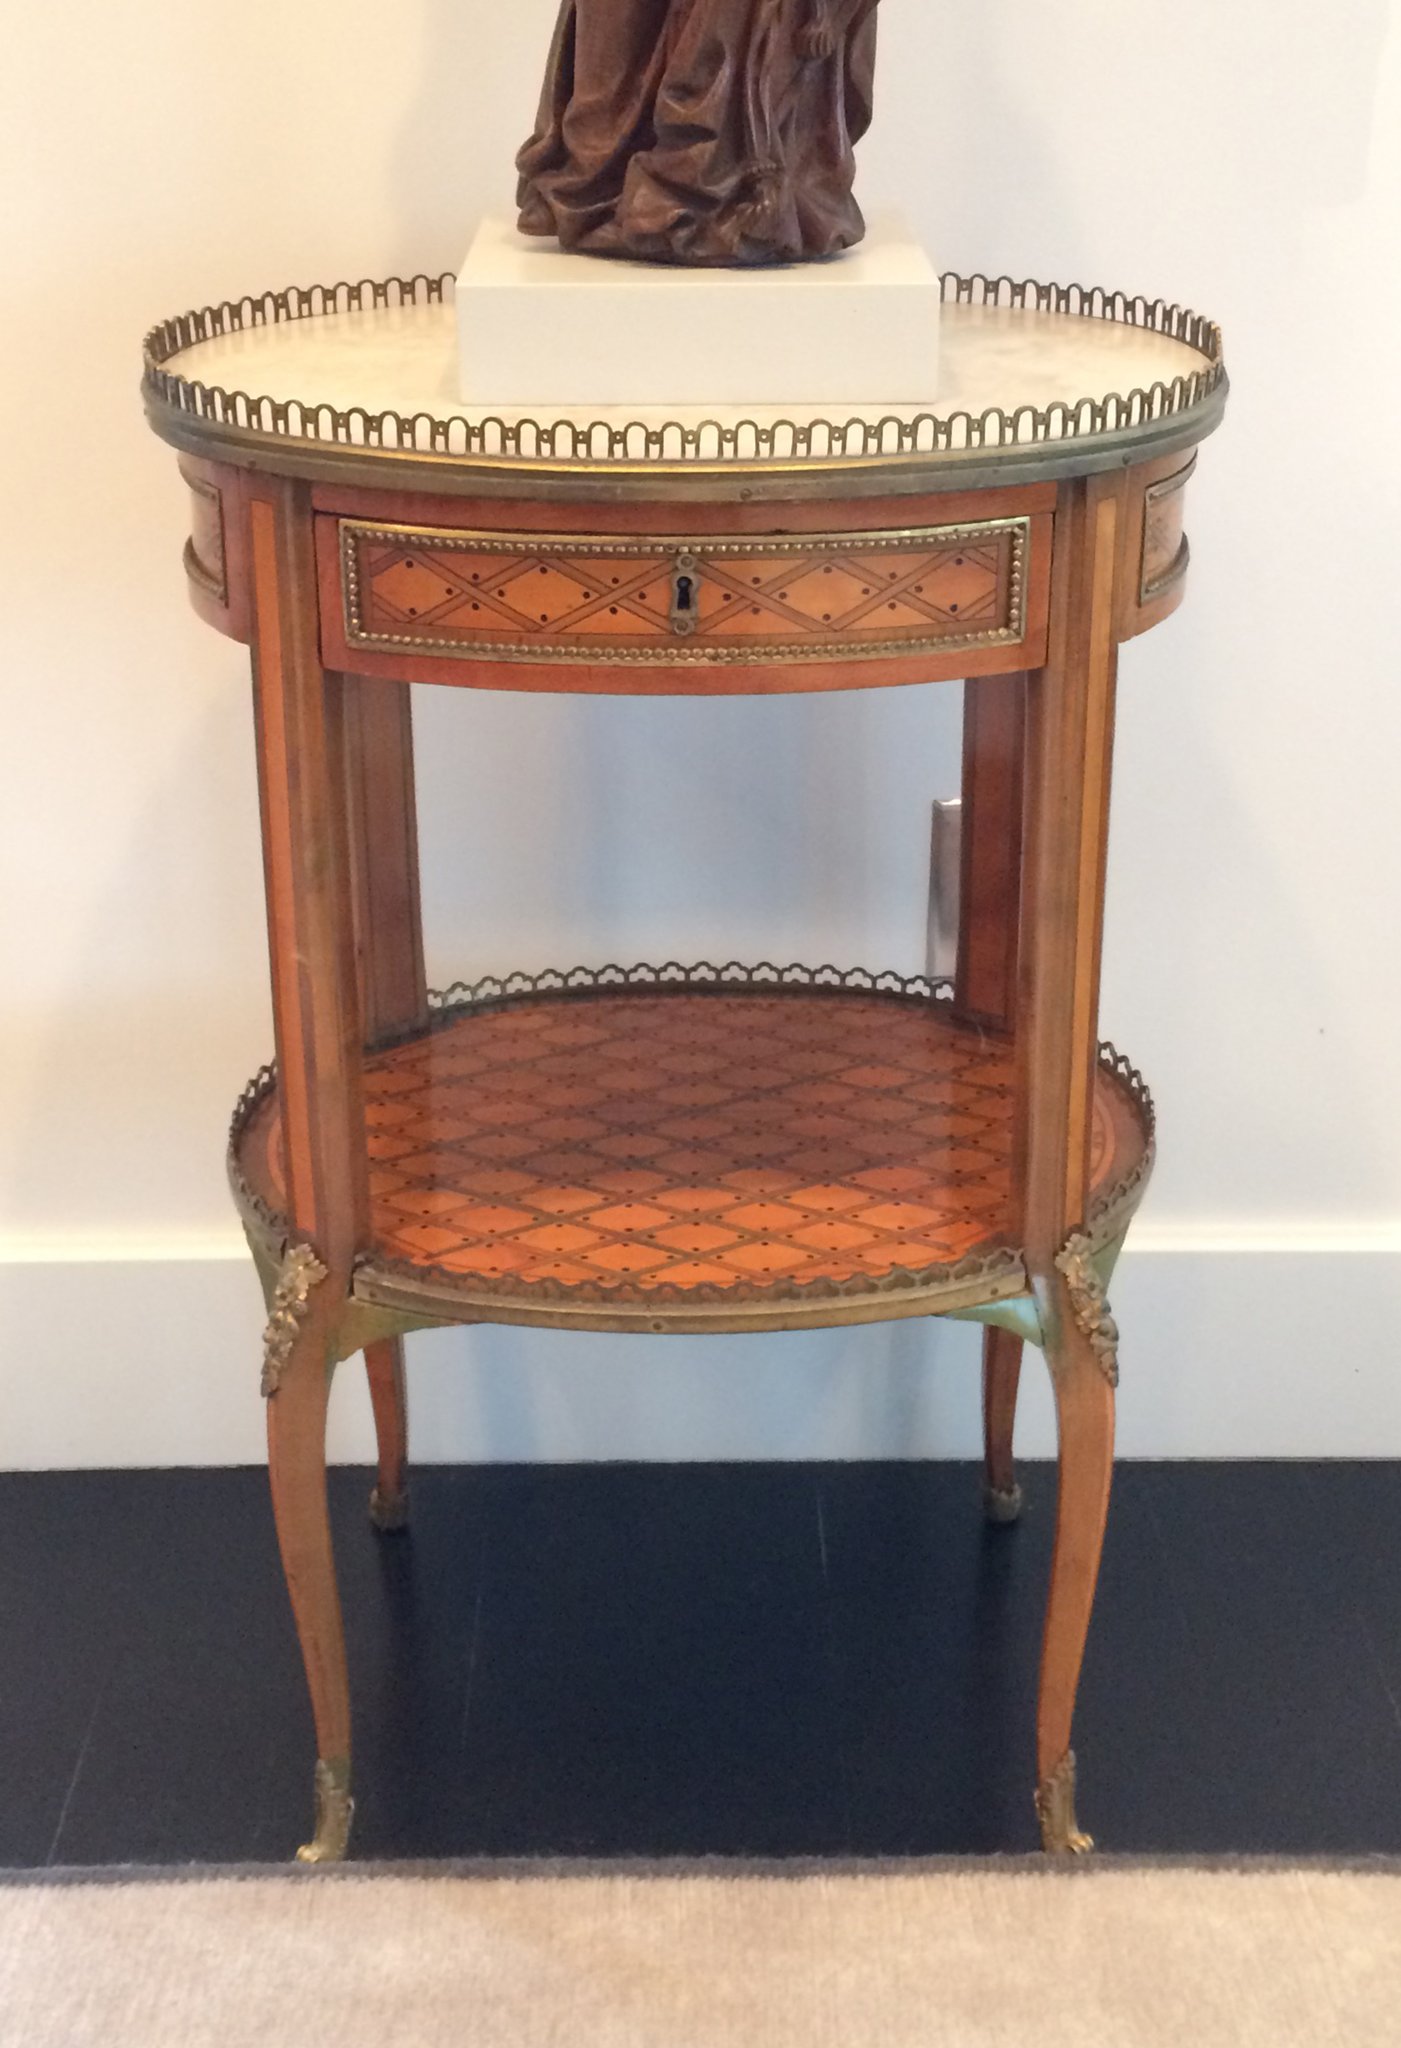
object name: table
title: Small oval table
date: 1775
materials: gilt bronze, wood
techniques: stain